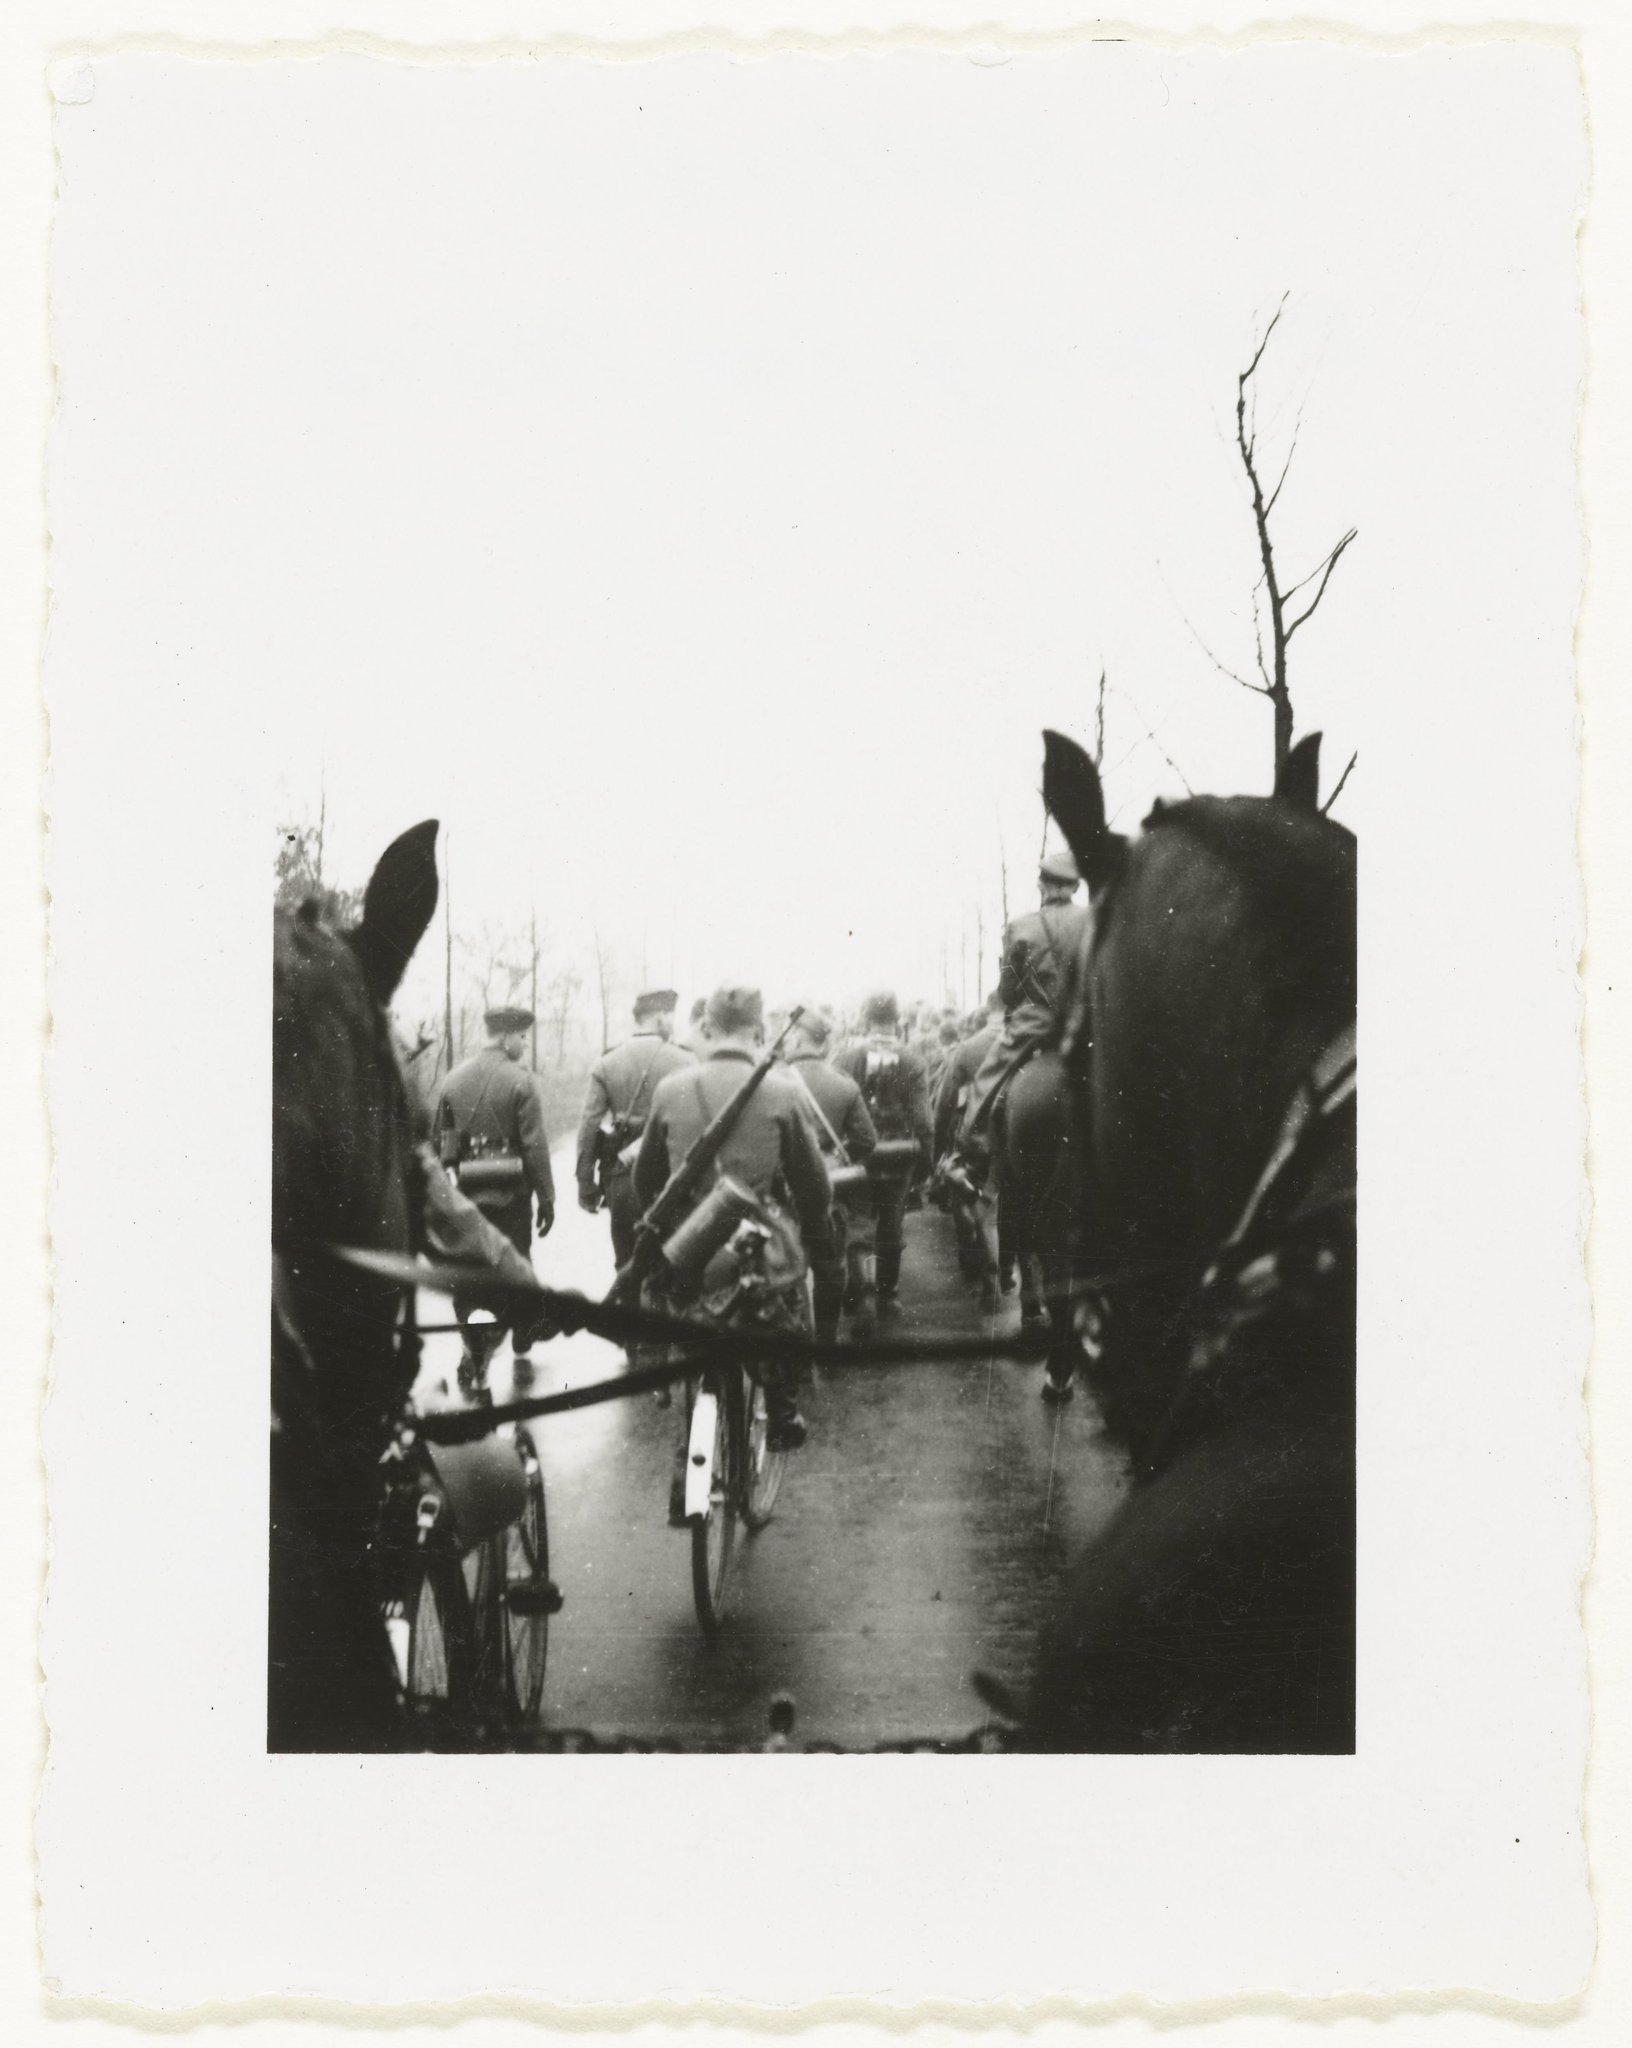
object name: photograph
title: Wehrmacht soldaten op oefening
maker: Anonymous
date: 1903-1941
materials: photographic support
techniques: gelatin silver print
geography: raamsdonksveer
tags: army 'en route', occupation ~ war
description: Wehrmacht soldaten op oefening op de fiets. Op de voorgrond de hoofden van twee paarden. Achterop staat: In Holland. Übung im März.